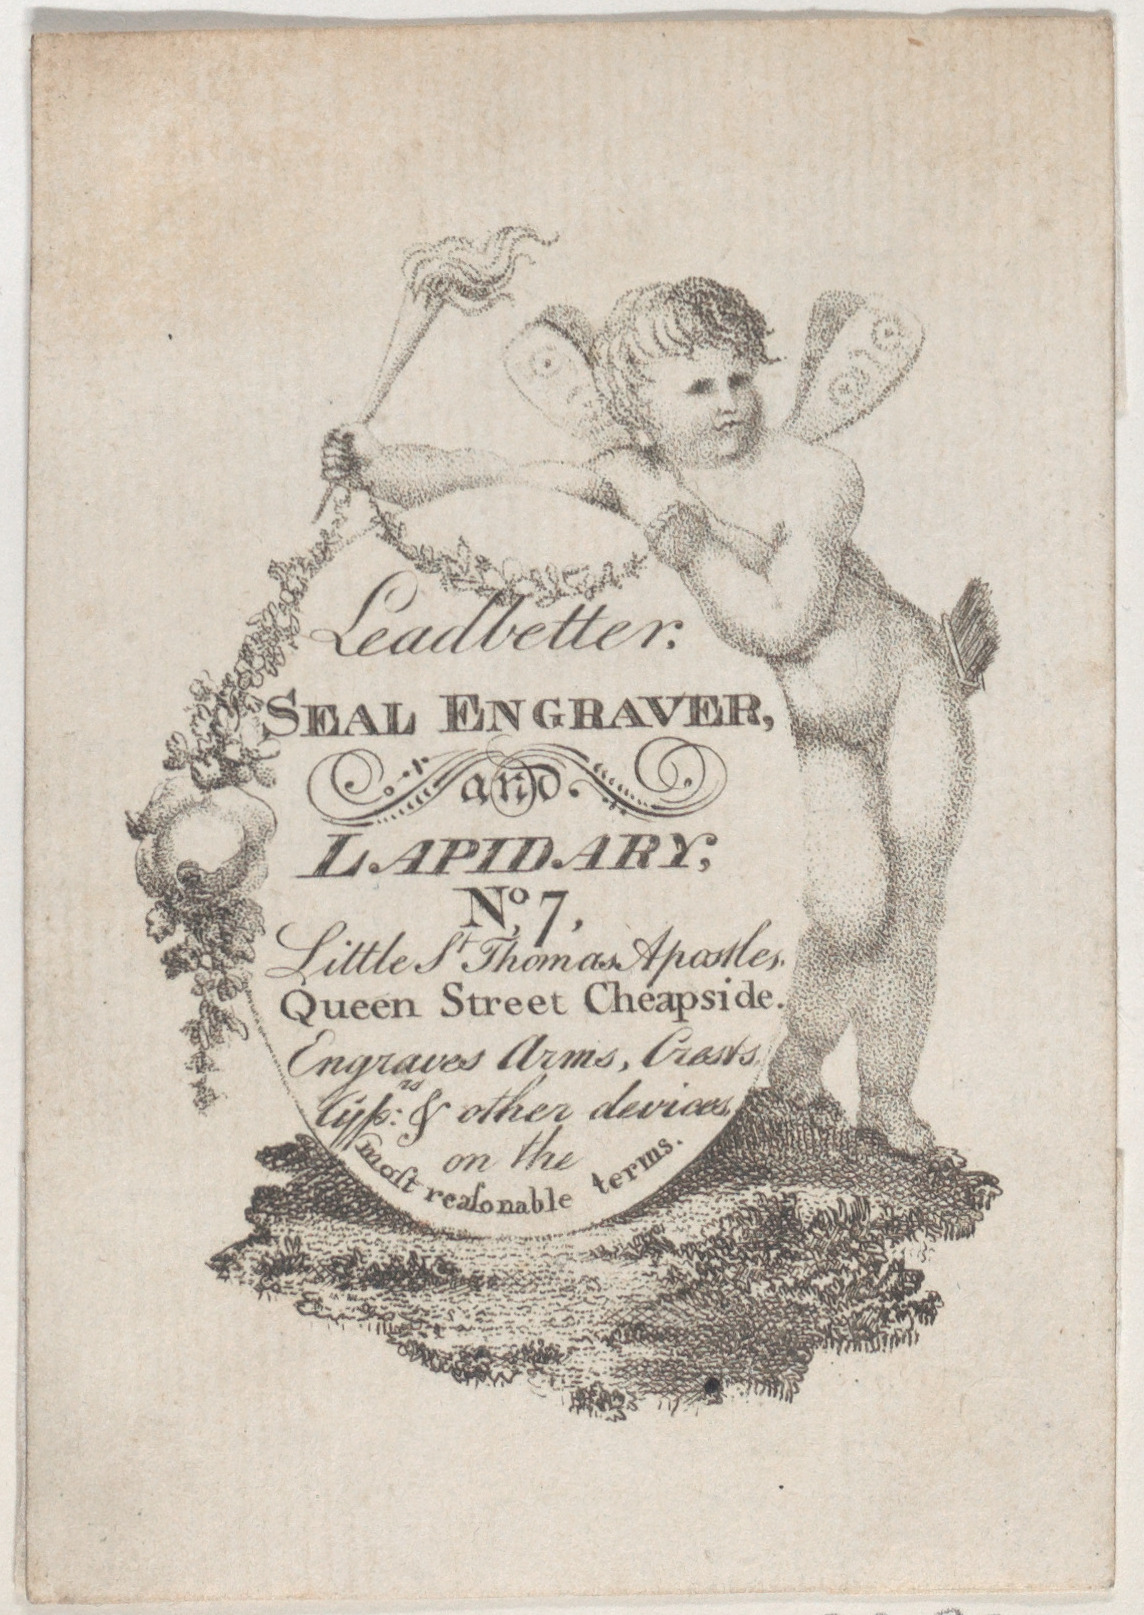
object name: print, trade card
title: Trade Card for Leadbetter, Seal Engraver and Lapidary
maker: anonymous, british, 19th century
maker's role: artist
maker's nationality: british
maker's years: 1800-1900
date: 1801-1900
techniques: engraving